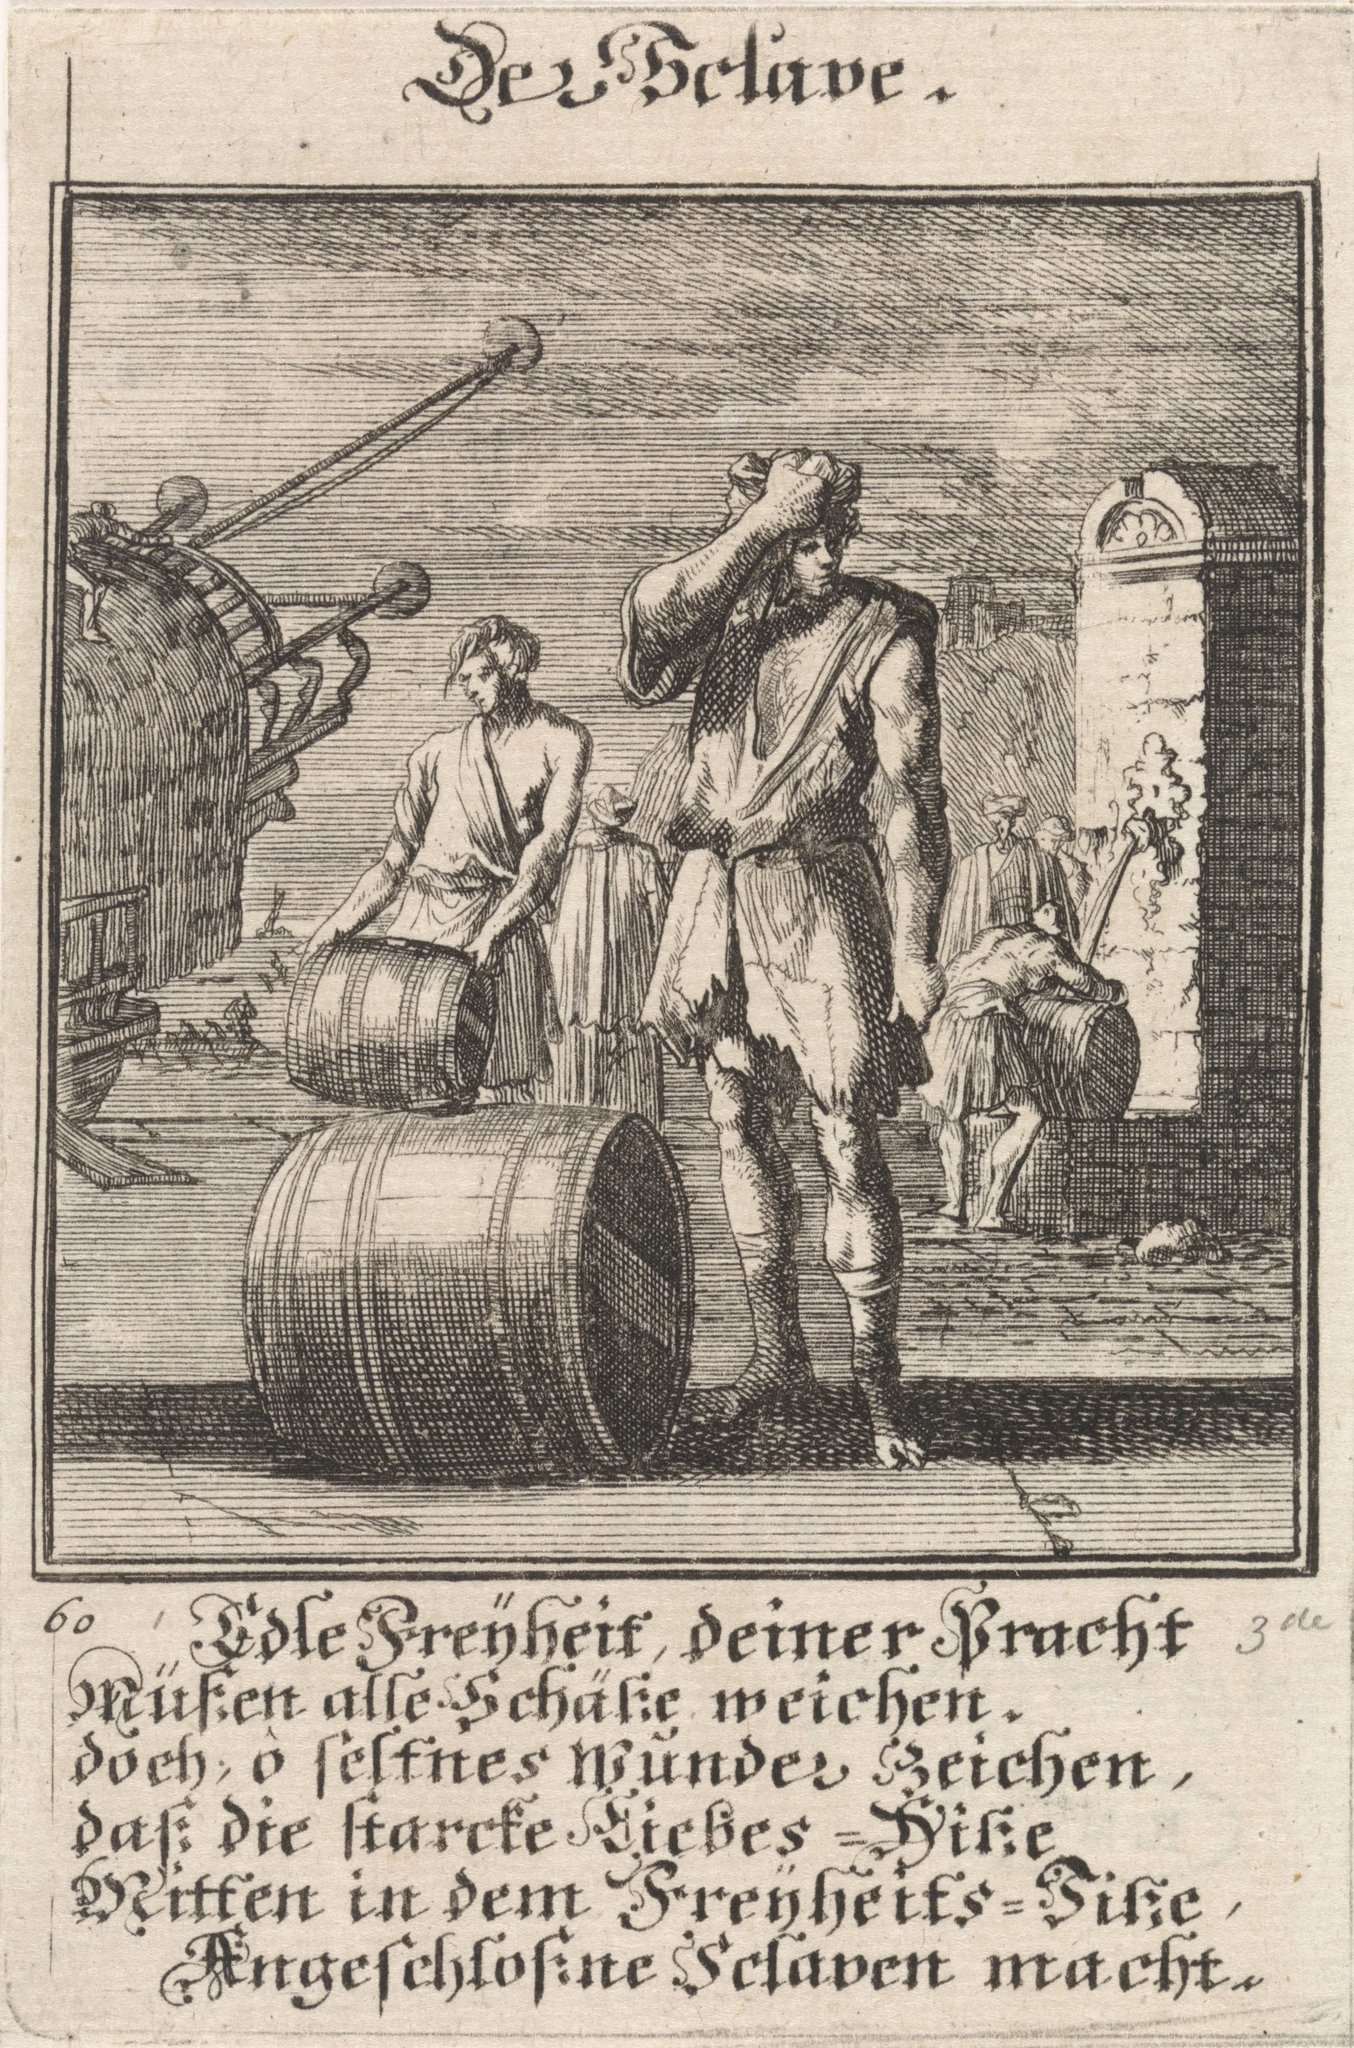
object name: book illustration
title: Slaaf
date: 1711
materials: paper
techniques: etching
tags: slavery; serfs and enslaved persons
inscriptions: collector's mark: Lugt 2228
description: Illustratie uit: Sancta Clara, Abraham à. Etwas für Alle, das ist: Eine kurtze Beschreibung allerley Stands- Ambts- und Gewerbs-Persohnen (...), 3 delen (1699-1733). Würtzburg: Martin Frantz Hertz, 1711, dl. III, p. 563. Het betreft hier de tweede druk van deel III.